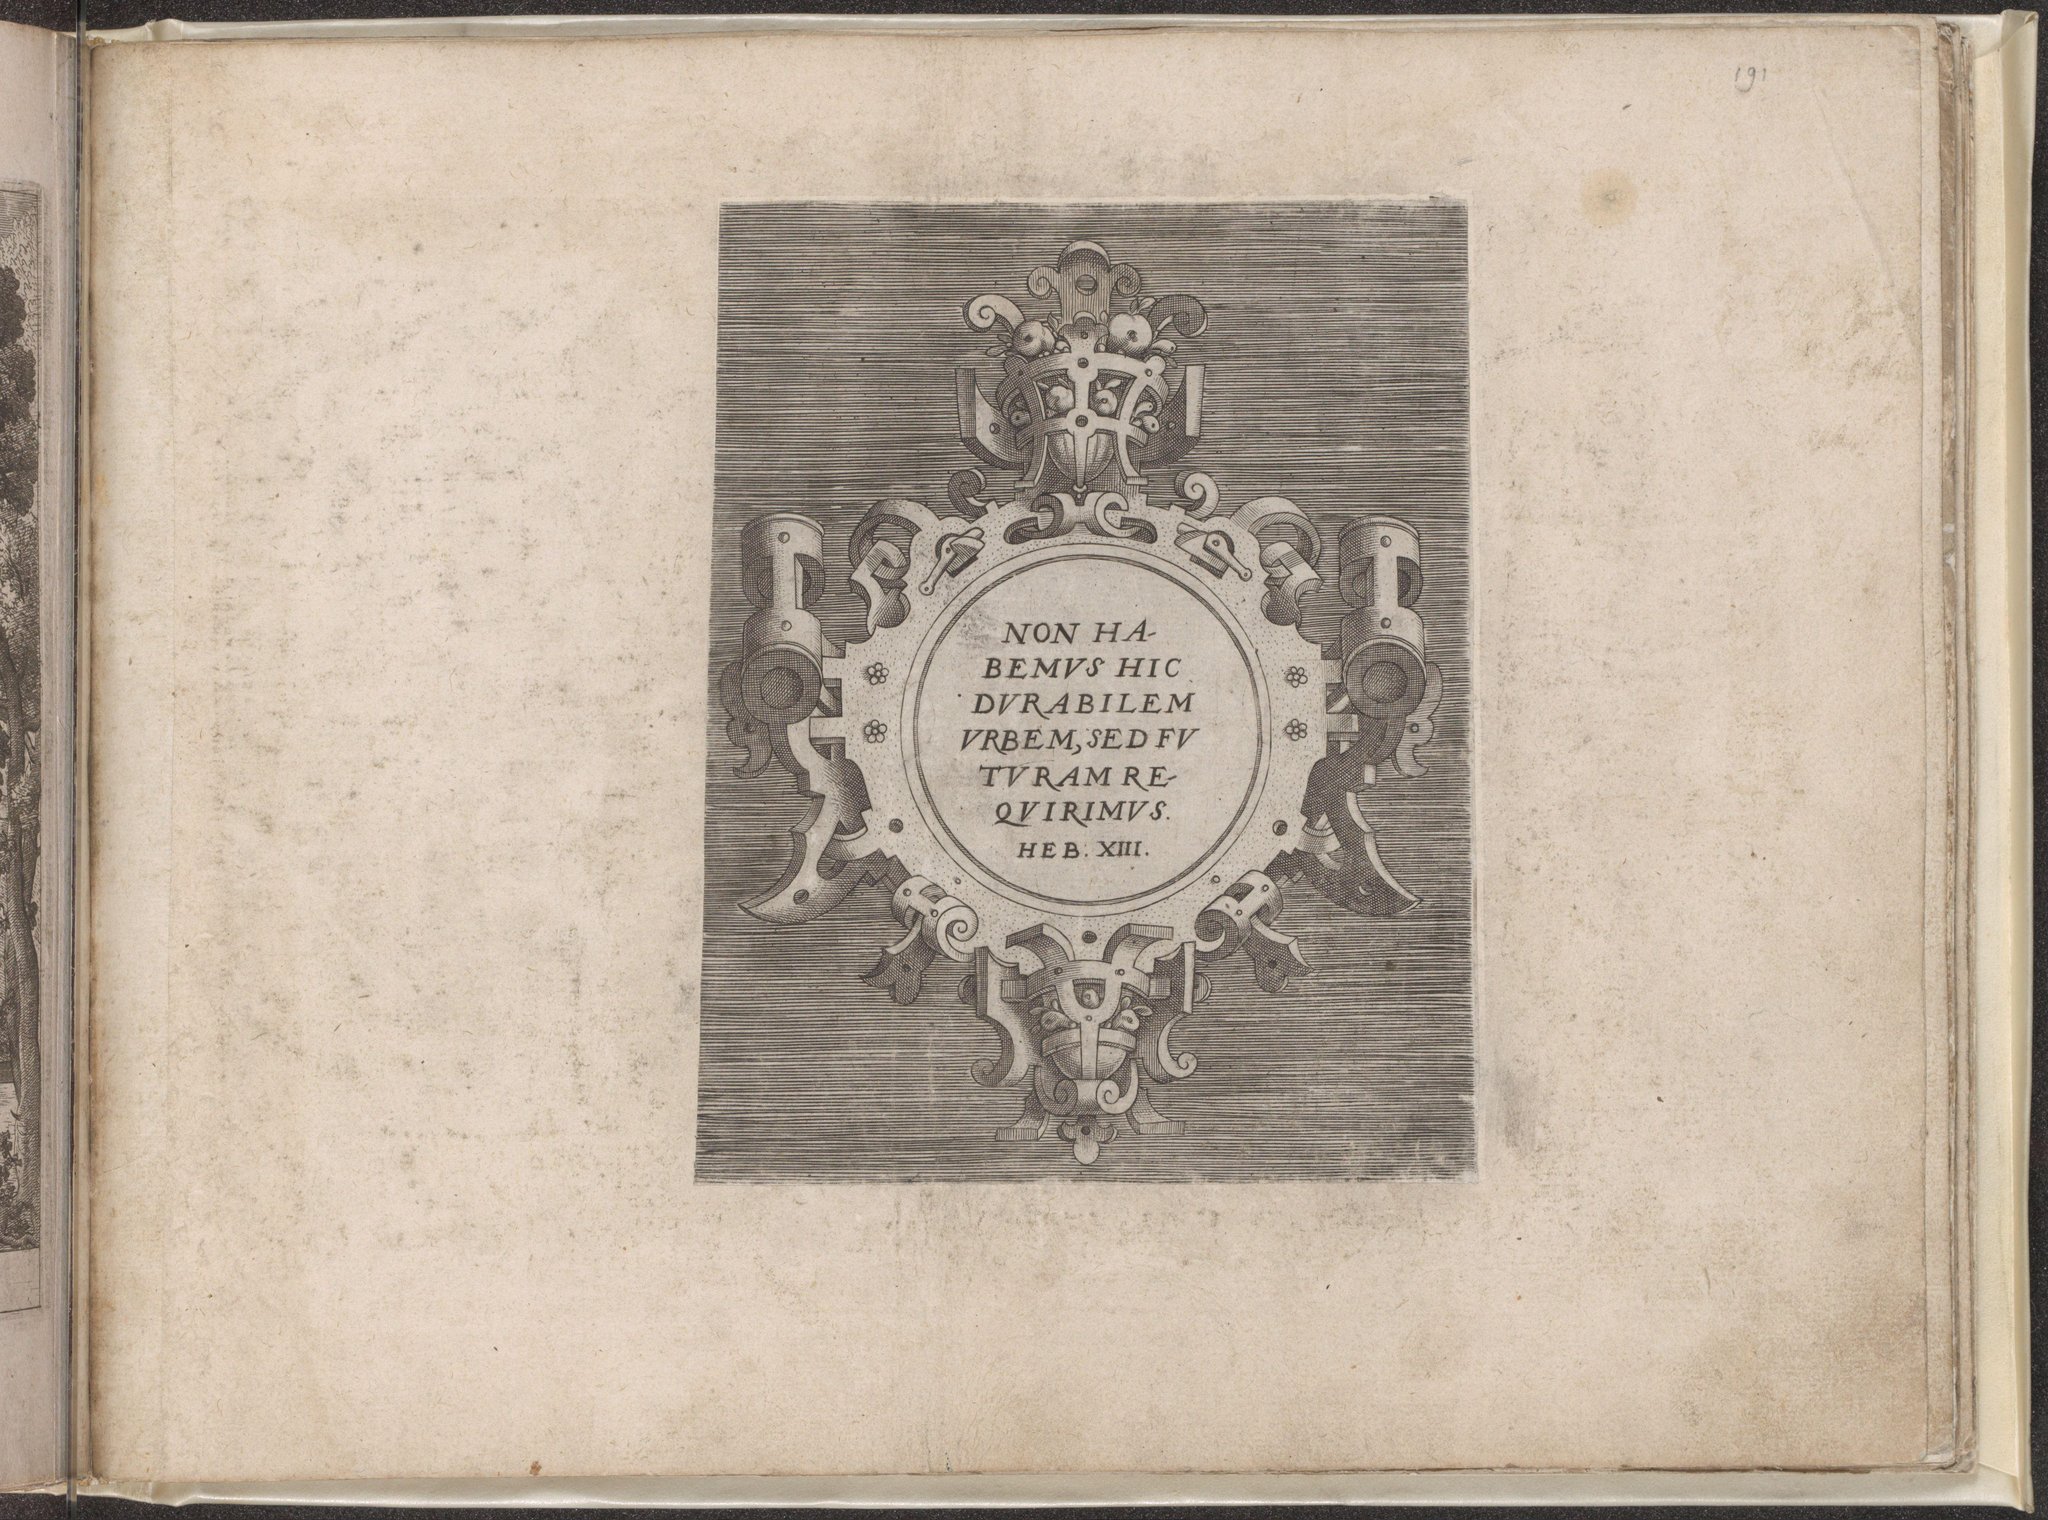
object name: album leaf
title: Cartouche met een tekst uit het Bijbelboek Hebreeën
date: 1555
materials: paper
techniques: engraving, etching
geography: antwerp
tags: vase ~ ornament, ornament ~ cartouche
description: Rond cartouche met een tekst uit Heb. 13:14. Rondom een ornamentele lijst met midden boven een bloemenvaas. Deze prent maakt deel uit van een album.